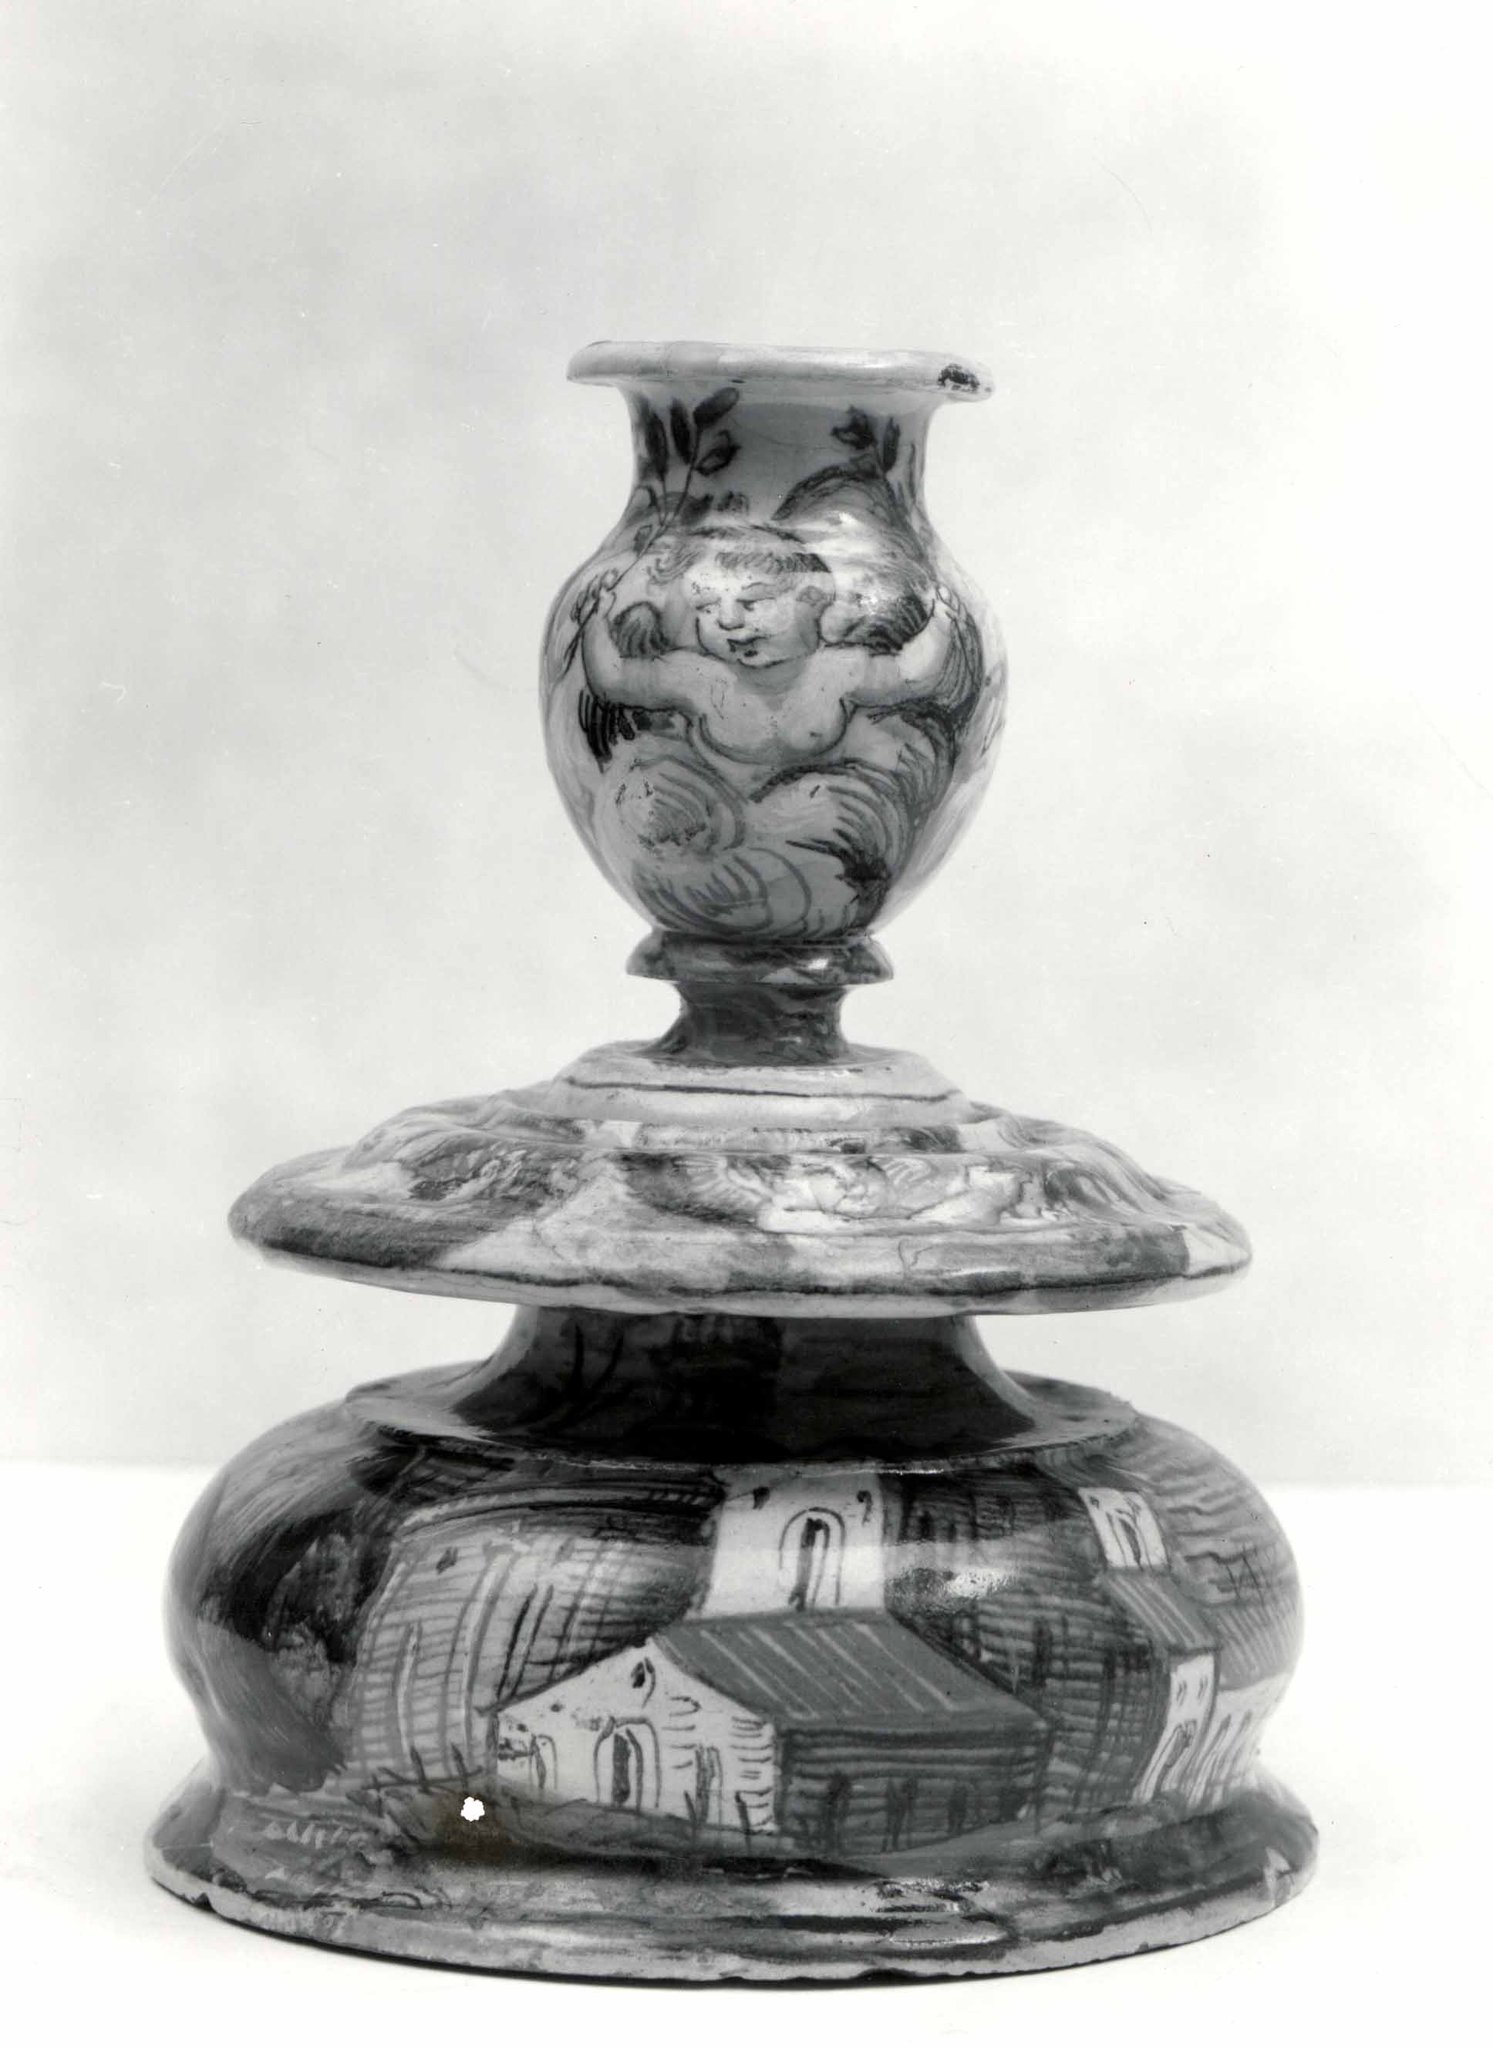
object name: candlestick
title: Maiolica: Candlestick (candeliere)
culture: italian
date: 1560-1580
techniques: maiolica, glazing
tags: putti,landscapes